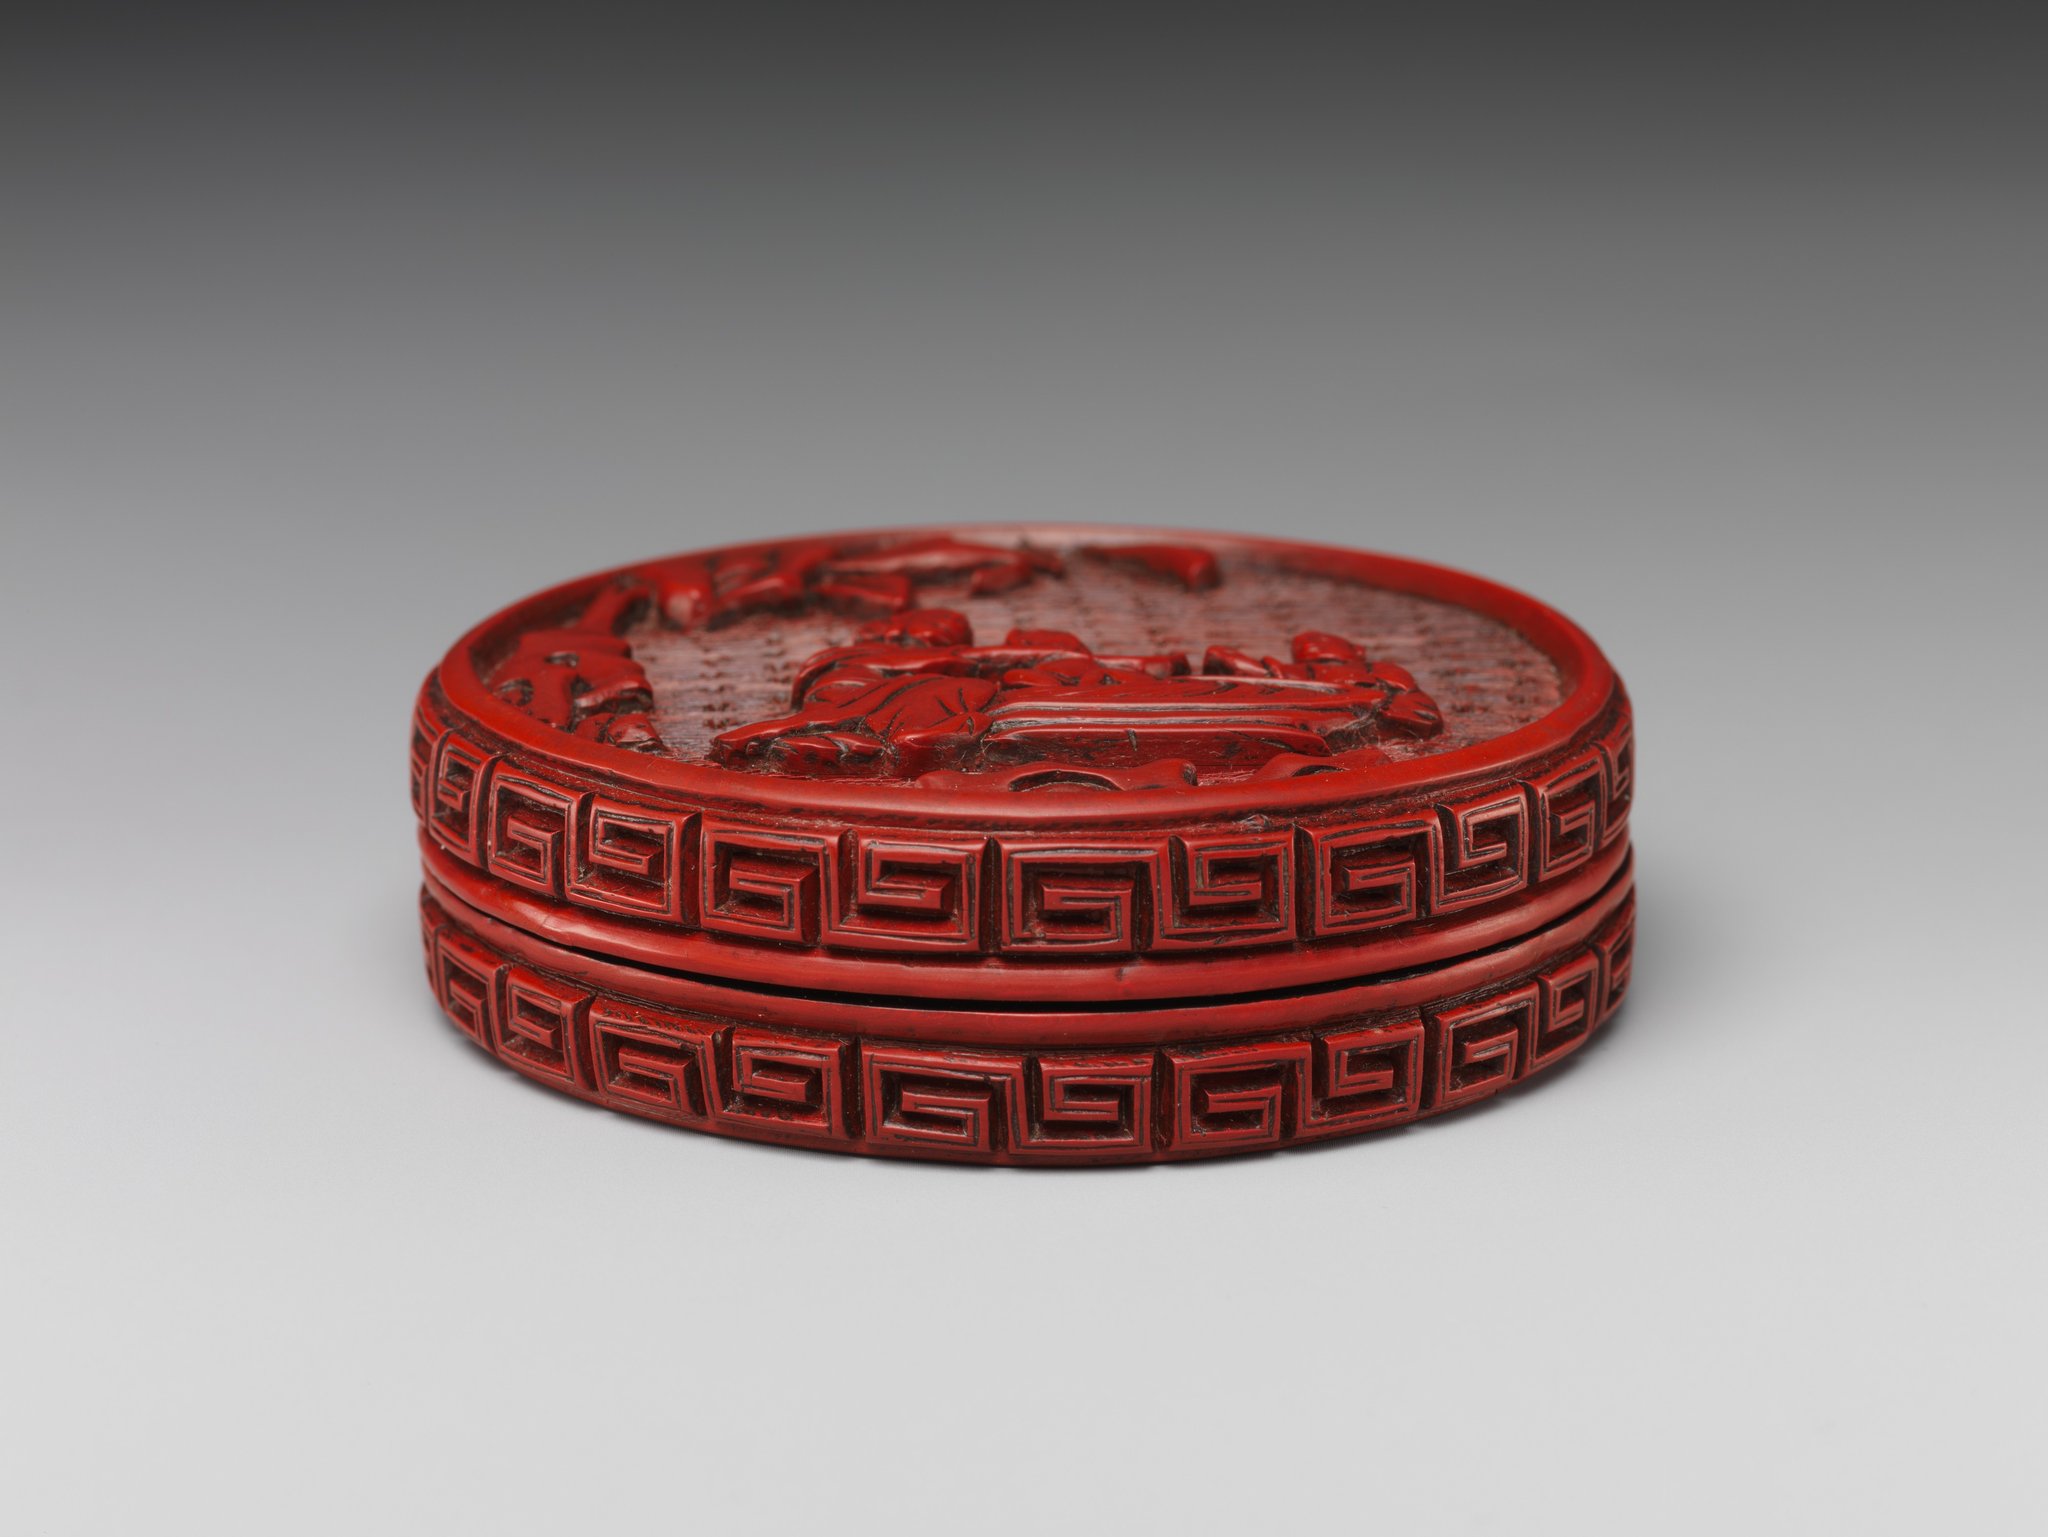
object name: box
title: Box with scene of bathing children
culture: chinese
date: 1301-1400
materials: lacquer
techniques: carving